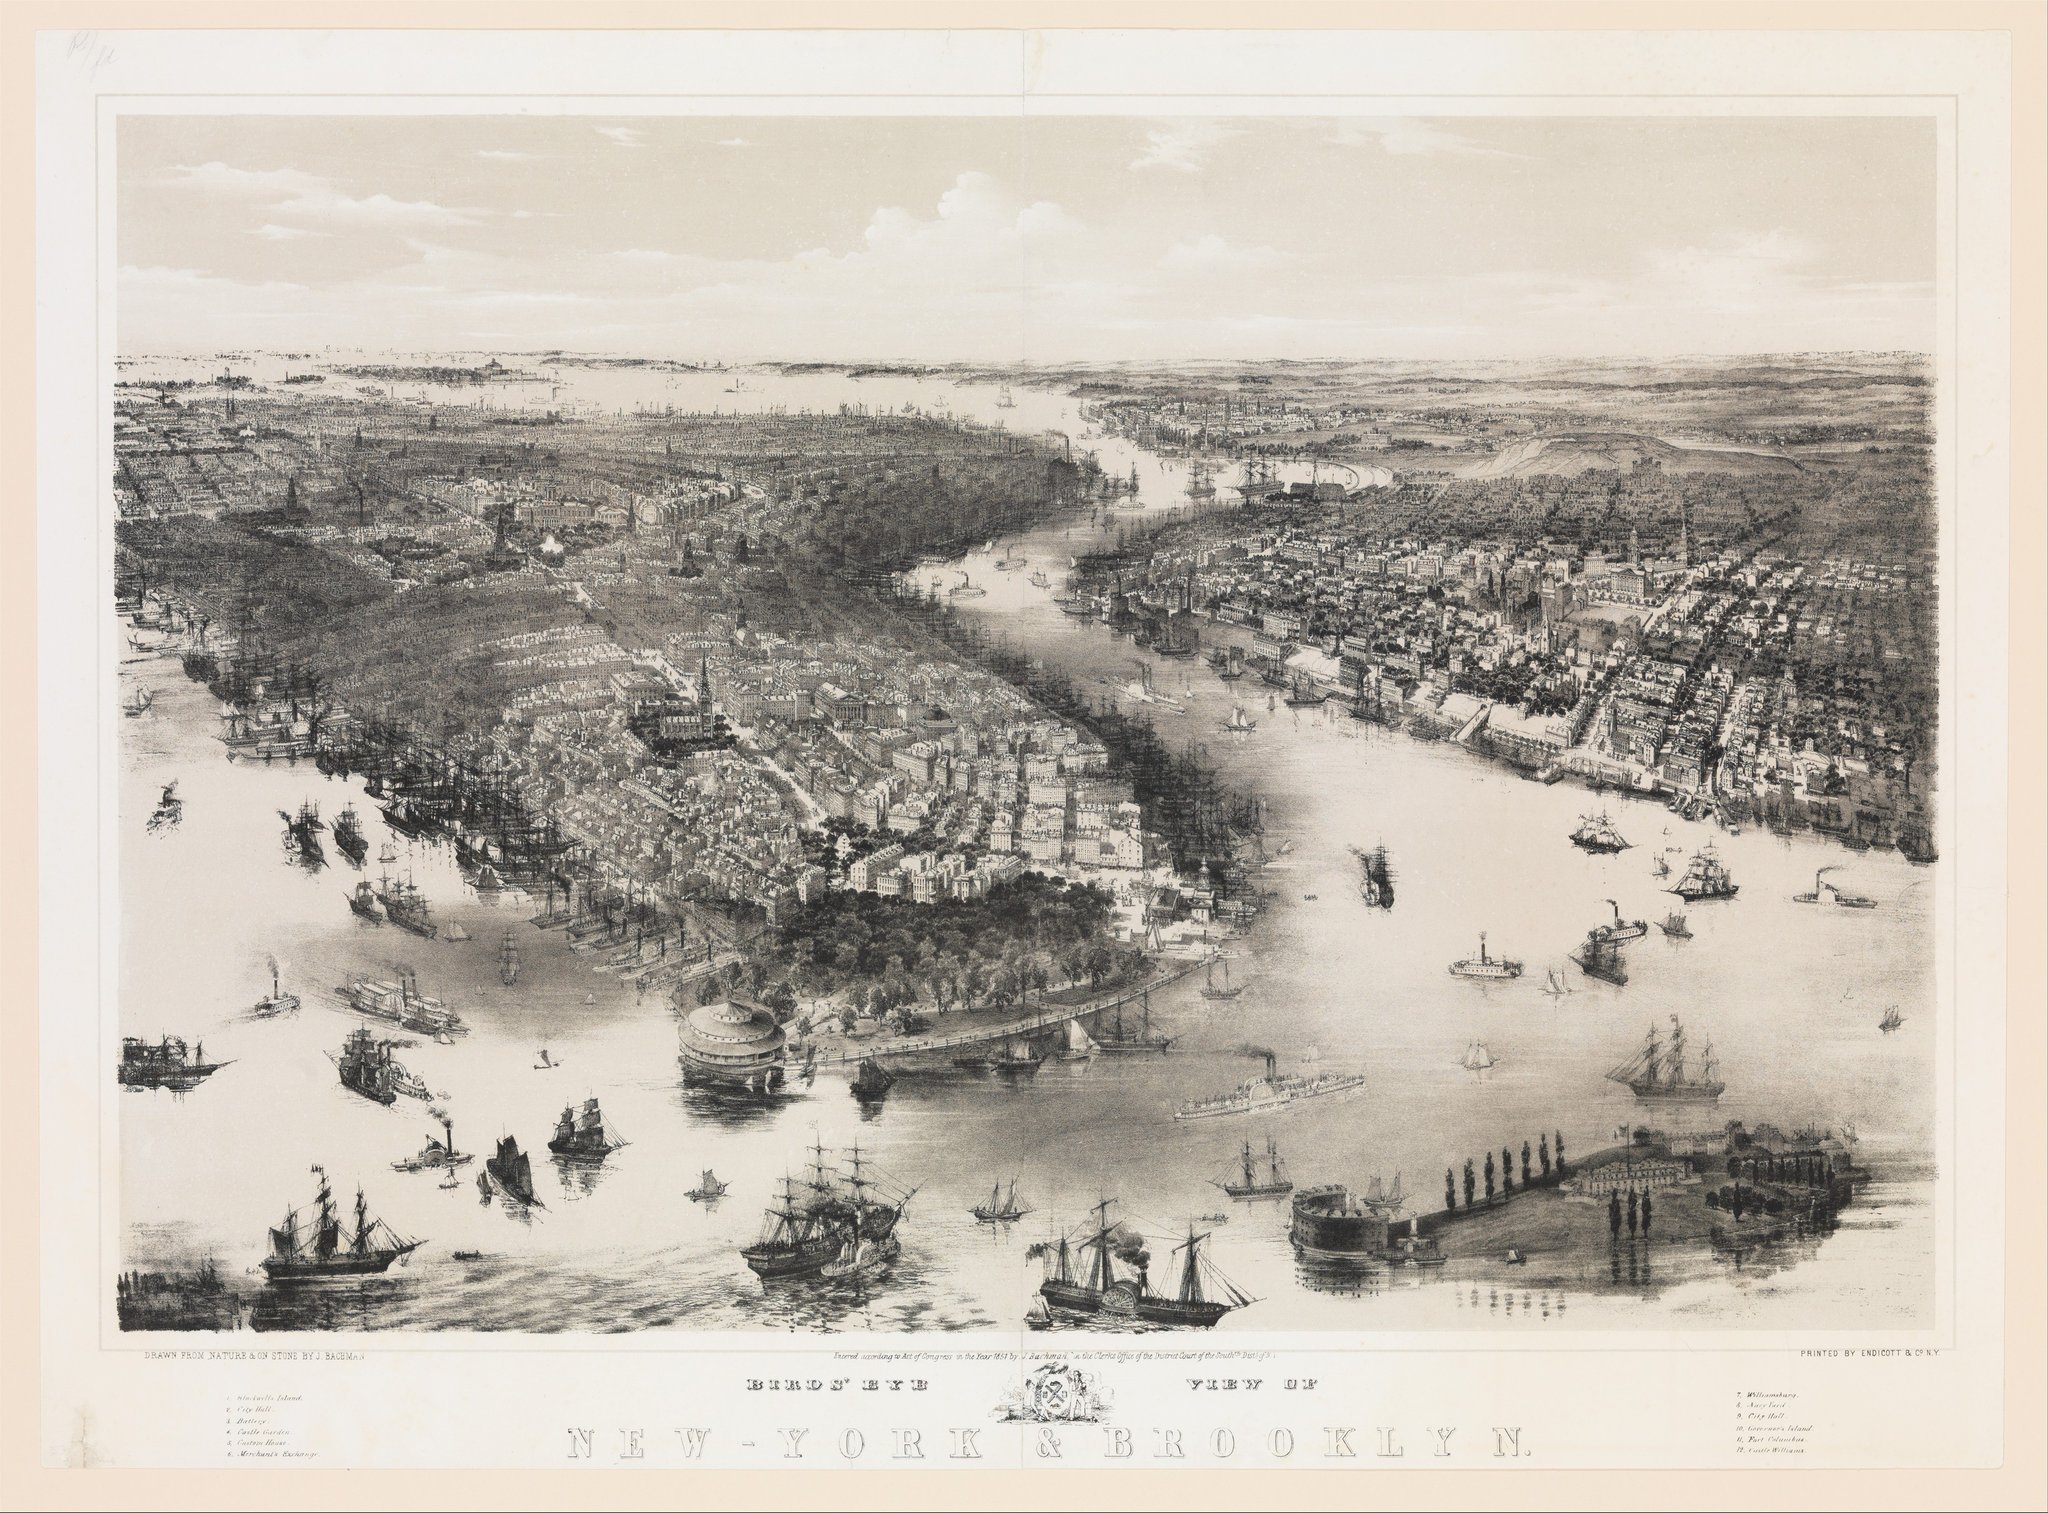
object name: print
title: Bird's Eye View of New York and Brooklyn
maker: john bachmann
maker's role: artist and publisher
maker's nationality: american, swiss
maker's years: 1814-1896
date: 1851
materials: stone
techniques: lithograph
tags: buildings,cities,boats,new york city